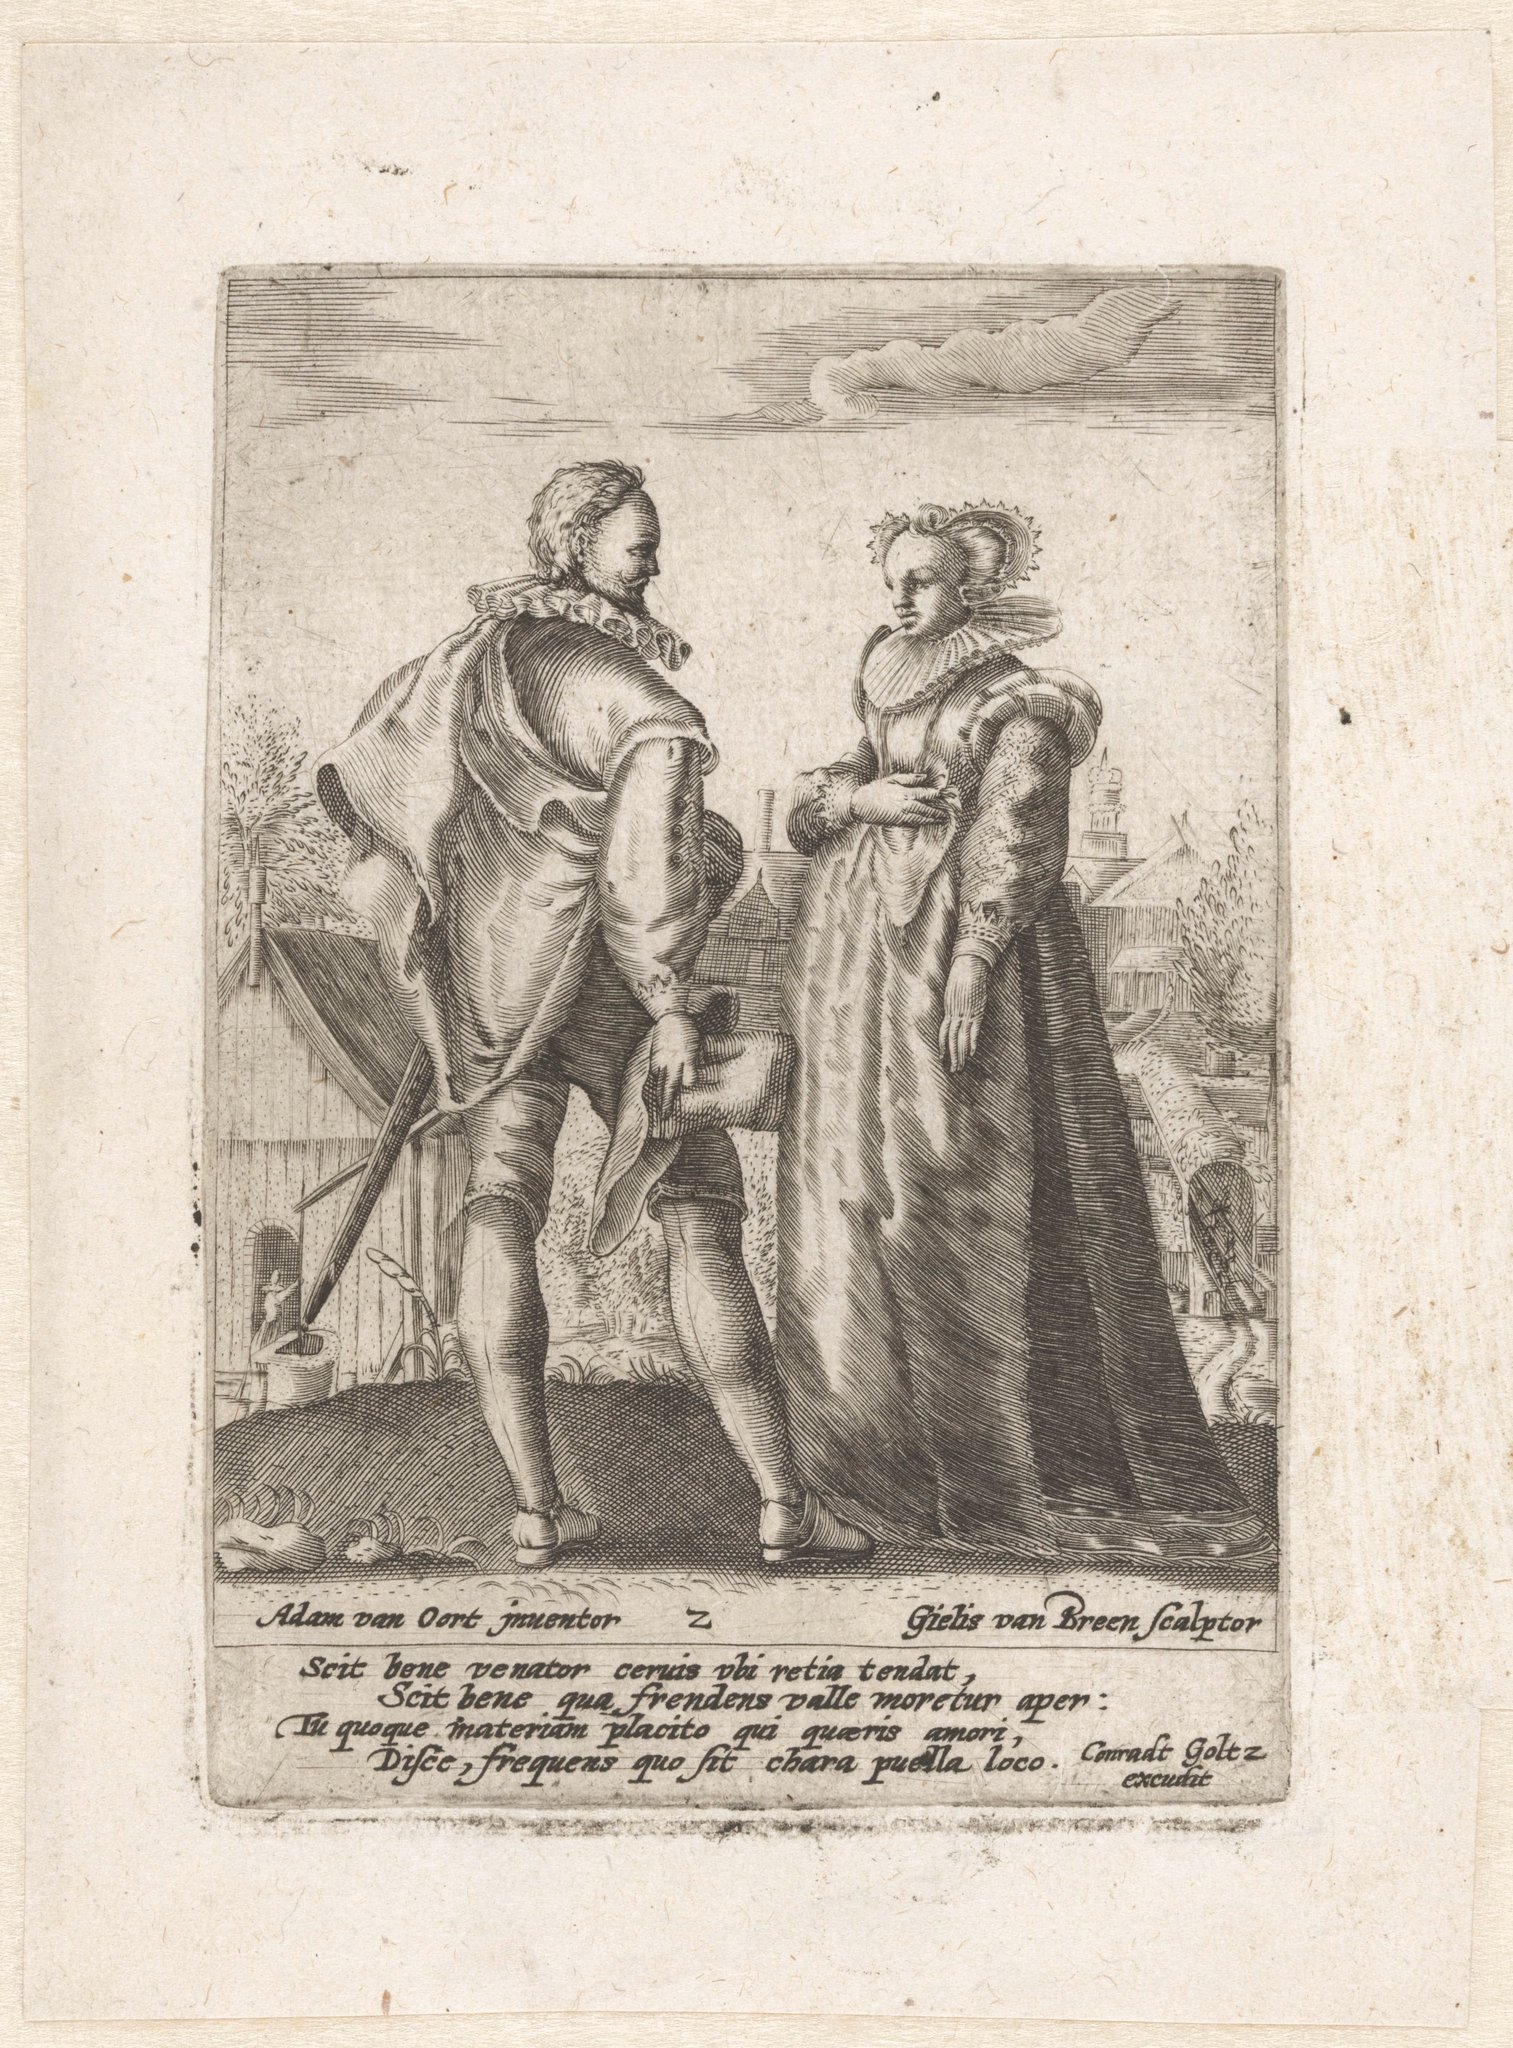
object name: print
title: Wandelend jong paar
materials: paper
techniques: engraving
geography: low countries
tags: clothes, costume (+ women's clothes), clothes, costume (+ men's clothes), couple of lovers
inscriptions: collector's mark: Lugt 2228, collector's mark: Lugt 2760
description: Mogelijk onderdeel van dezelfde serie als twee andere prenten van een jong paar, zie inv.nr. RP-P-1878-A-643 (nr. 4) en RP-P-OB-16.105 (nr. 1).